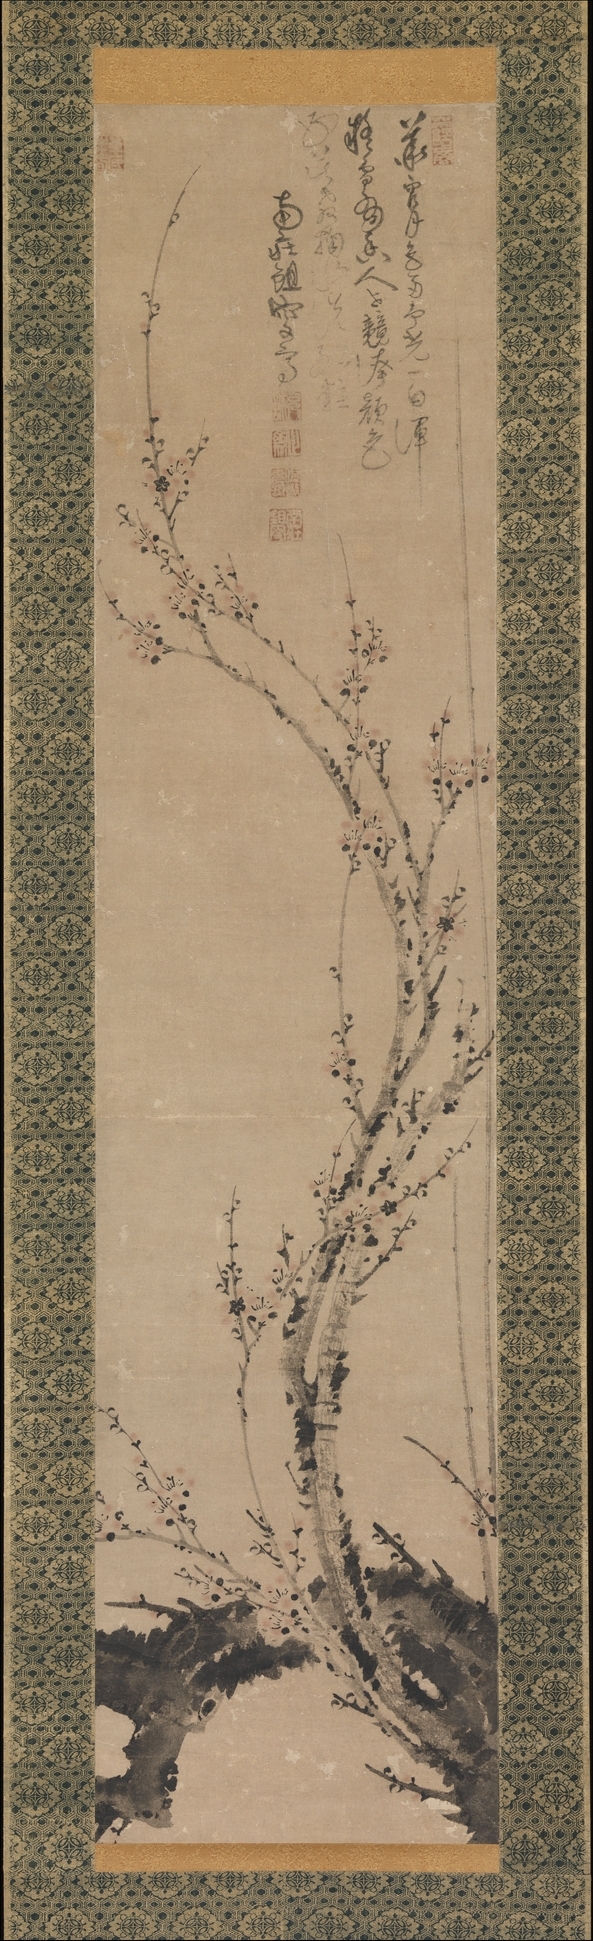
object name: hanging scroll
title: Wintry plum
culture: chinese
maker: ni jing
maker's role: artist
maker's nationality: chinese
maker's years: 1367-1399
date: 1301-1400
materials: ink, paper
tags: trees